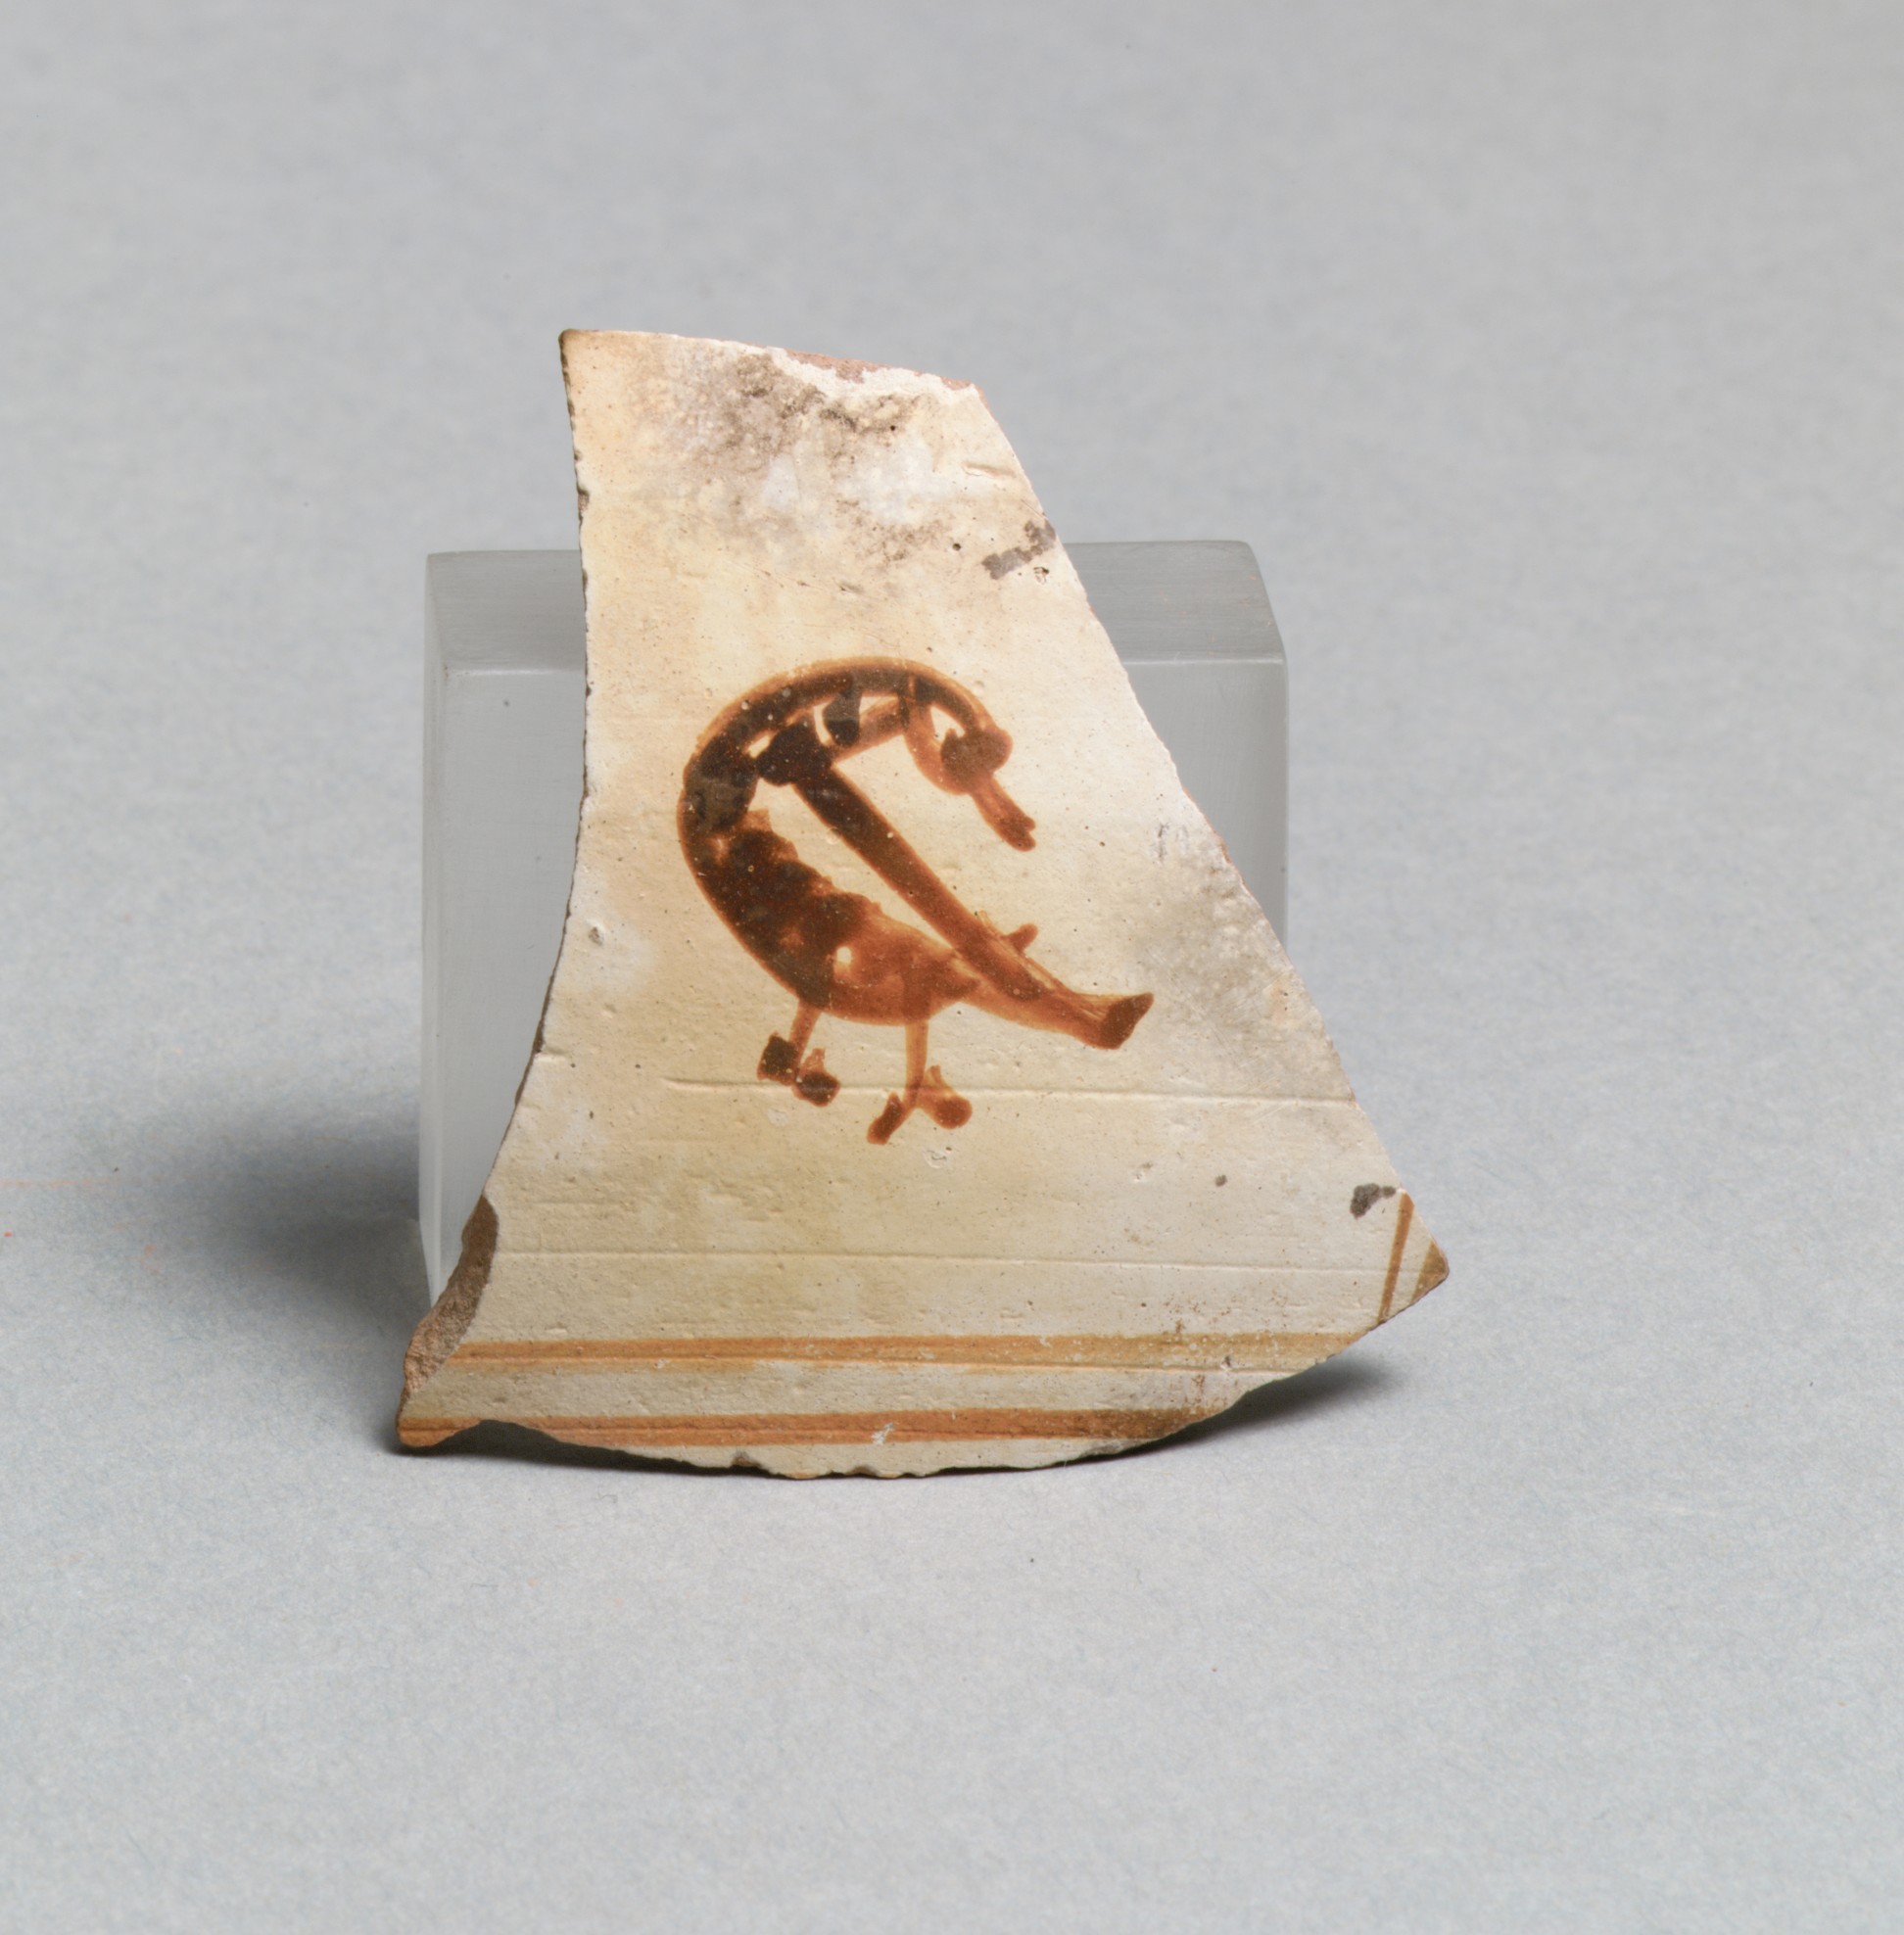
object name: vase fragment, 3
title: Vase fragments, 2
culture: greek or lydian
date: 900-30 BCE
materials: terracotta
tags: birds